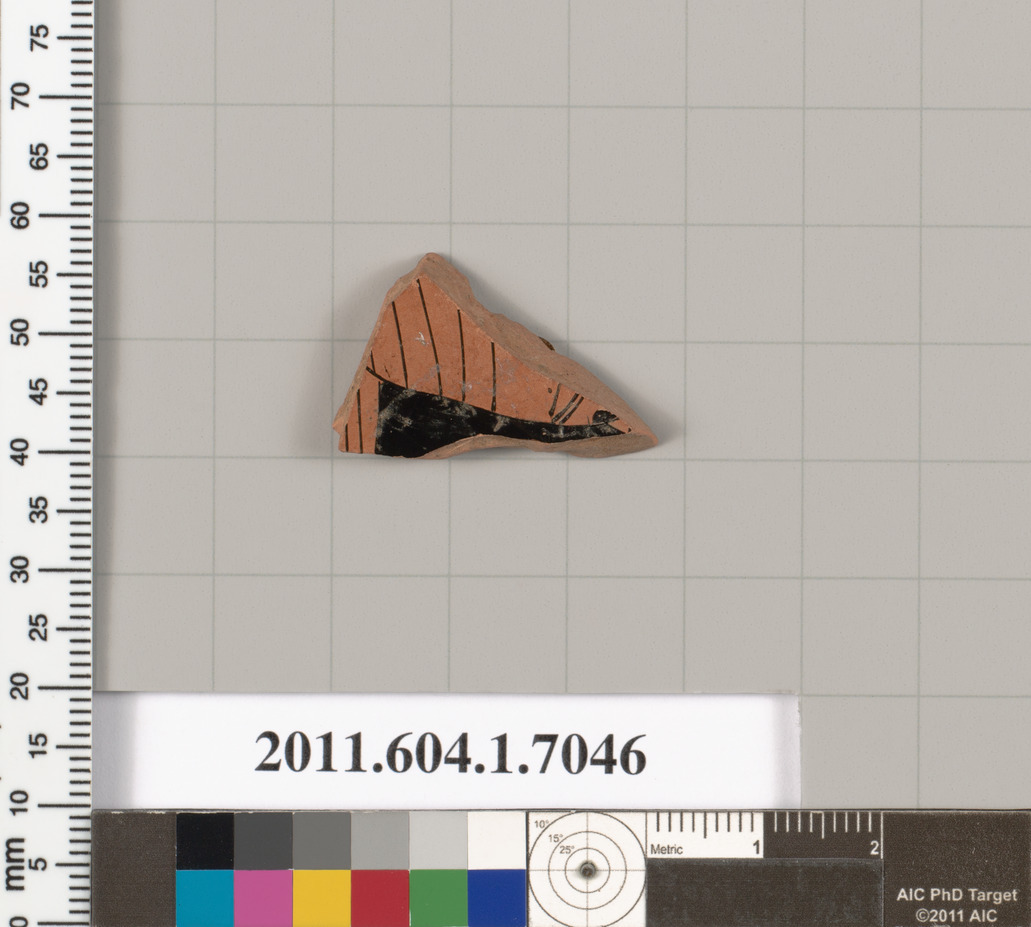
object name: kylix fragment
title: Terracotta fragment of a kylix (drinking cup)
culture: greek, attic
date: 500-480 BCE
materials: terracotta